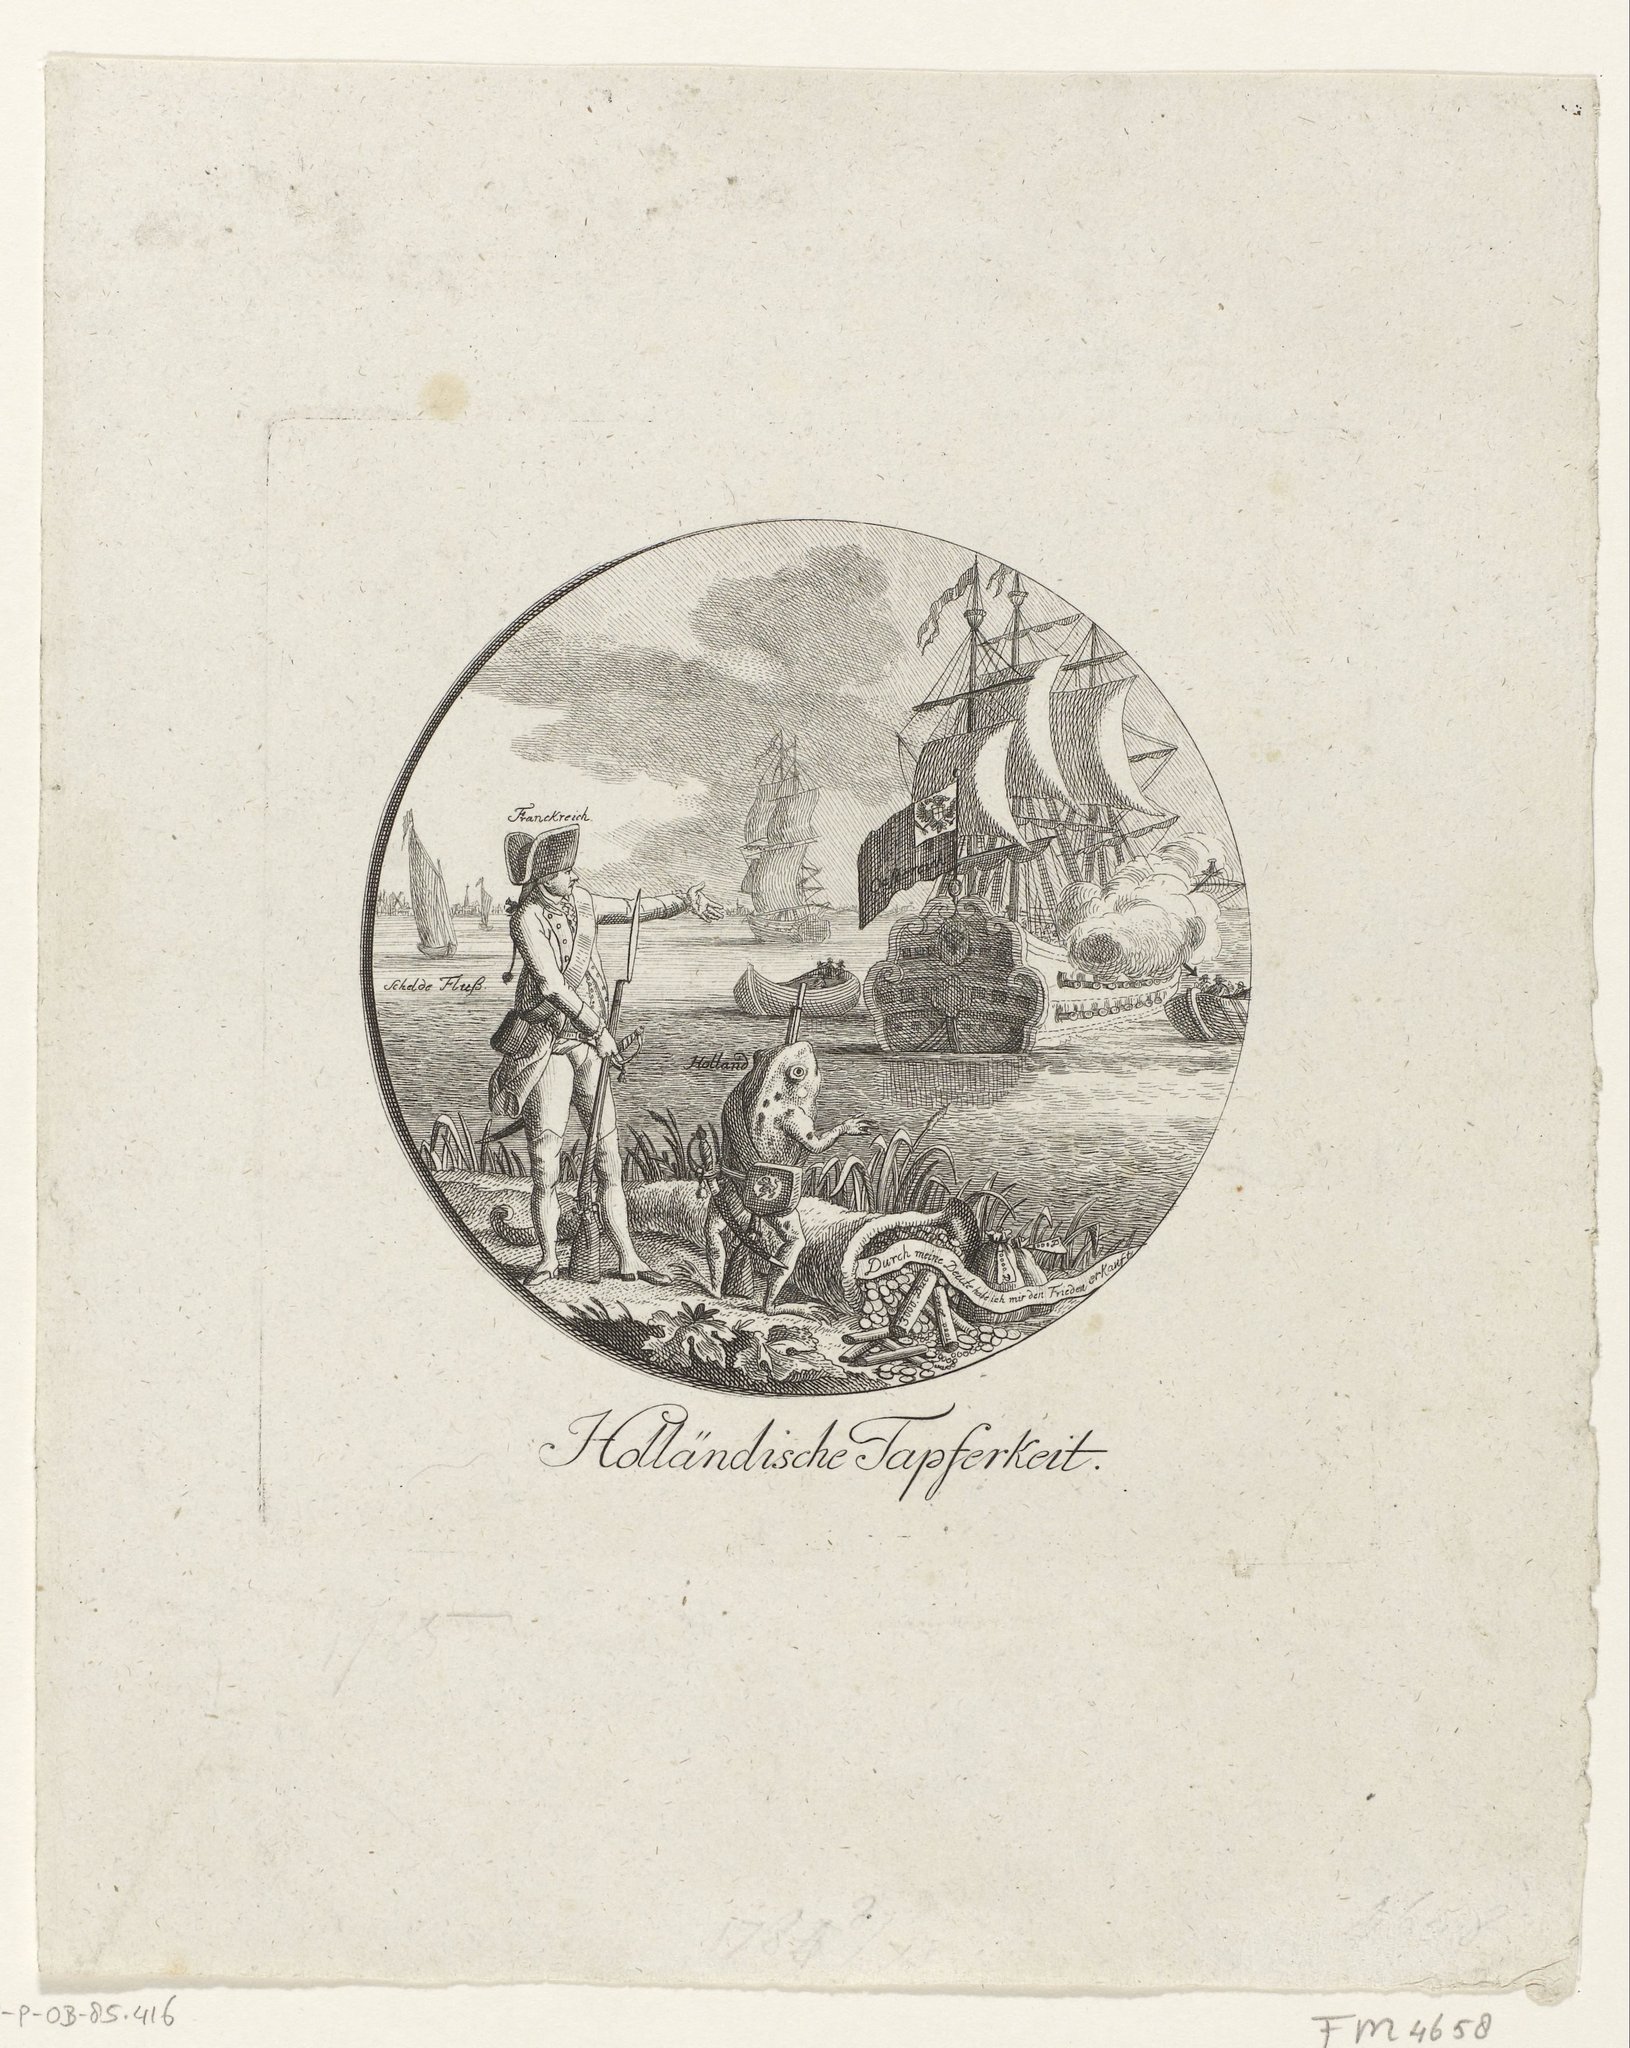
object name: cartoon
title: Holländische Tapferkeit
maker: Anonymous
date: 1785-1786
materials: paper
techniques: engraving, etching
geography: germany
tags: tailless amphibians: frog, france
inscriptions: collector's mark: Lugt 2228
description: Spotprent op het verdrag van Fontainebleau waarmee een eind kwam aan de Keteloorlog, de twisten tussen Nederland en de Oostenrijkse keizer Jozef II, 10 november 1785. Nederland betaalde 8,5 miljoen gulden en accepteerde andere vernederende voorwaarden. Ronde voorstelling met een Fransman en een Nederlandse kikker staande aan de oever van de Schelde, op het water het incident in oktober 1784 met de keizerlijke brik. Op de grond een hoorn van overvloed gevuld met muntstukken en geldzakken, de afkoopsom die Nederland voor vrede heeft moeten betalen.